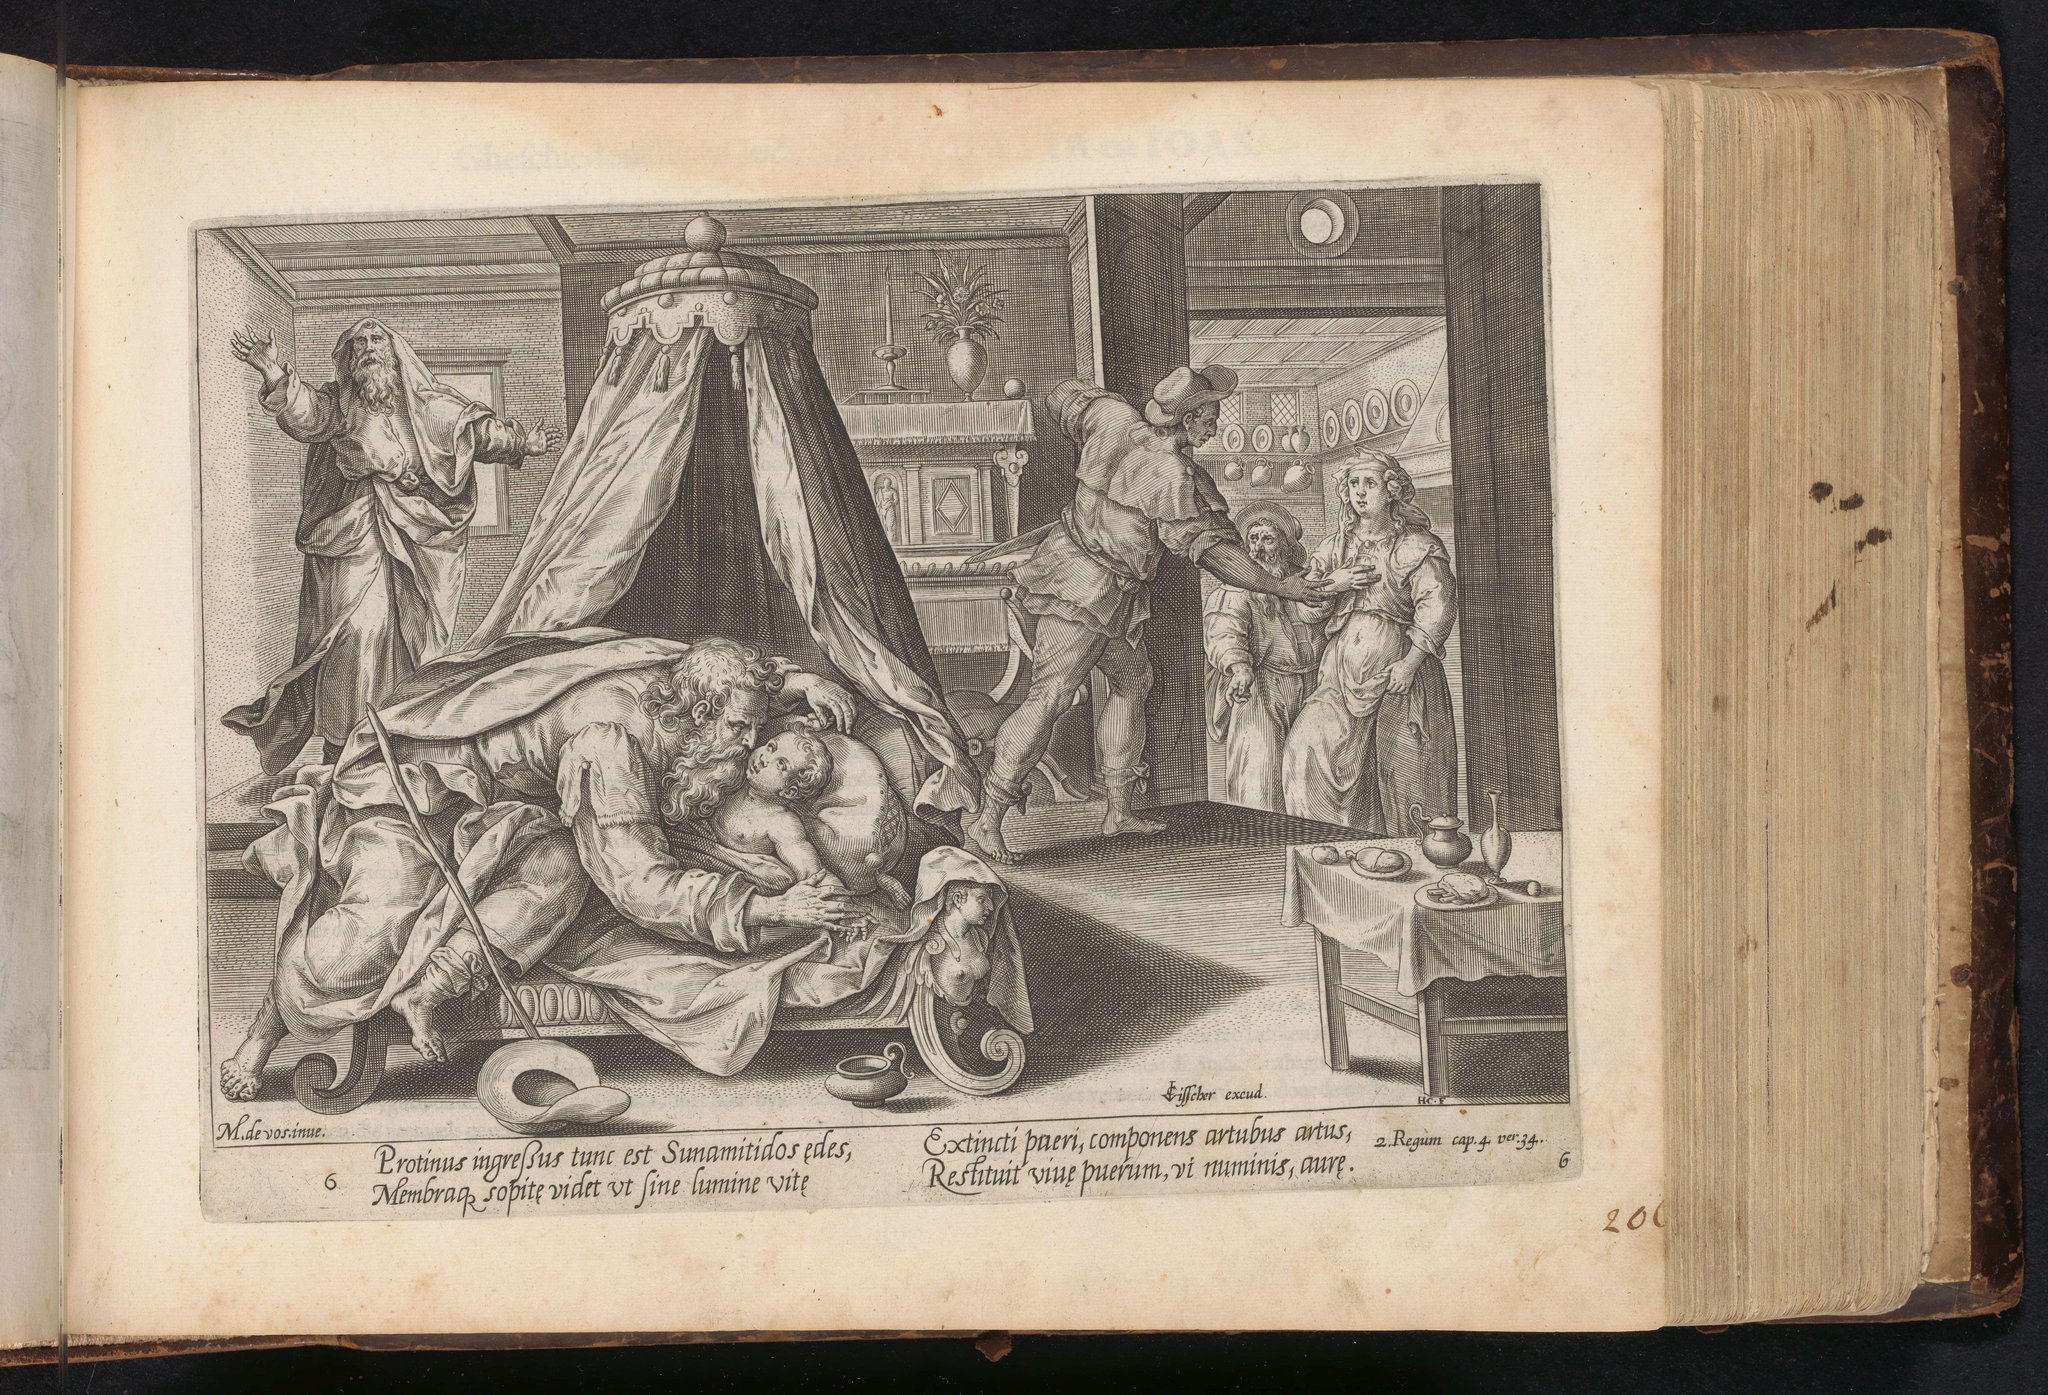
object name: album leaf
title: Geschiedenis van Elisa en de vrouw uit Sunem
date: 1579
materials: paper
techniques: engraving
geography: amsterdam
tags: elisha finds the son of the shunammite woman lying on his bed and prays to god, elisha stretches himself out upon the child of the shunammite woman, raising of the shunammite woman's son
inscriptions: number: ‘206’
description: Als Elisa is aangekomen sluit Gechazi rechts de deur van het vertrek. De ouders van de gestorven jongen blijven buiten het vertrek. Links bidt Elisa met geheven armen tot God. In het midden strekt hij zich uit over de gestoven jongen met zijn mond op zijn mond en zijn handpalmen op de handpalmen van de jongen. Zo wekt Elisa de jongen tot leven. Onder de voorstelling een verwijzing in het Latijn naar de Bijbeltekst in 2 Kon. 4:34. Deze prent maakt deel uit van een album.